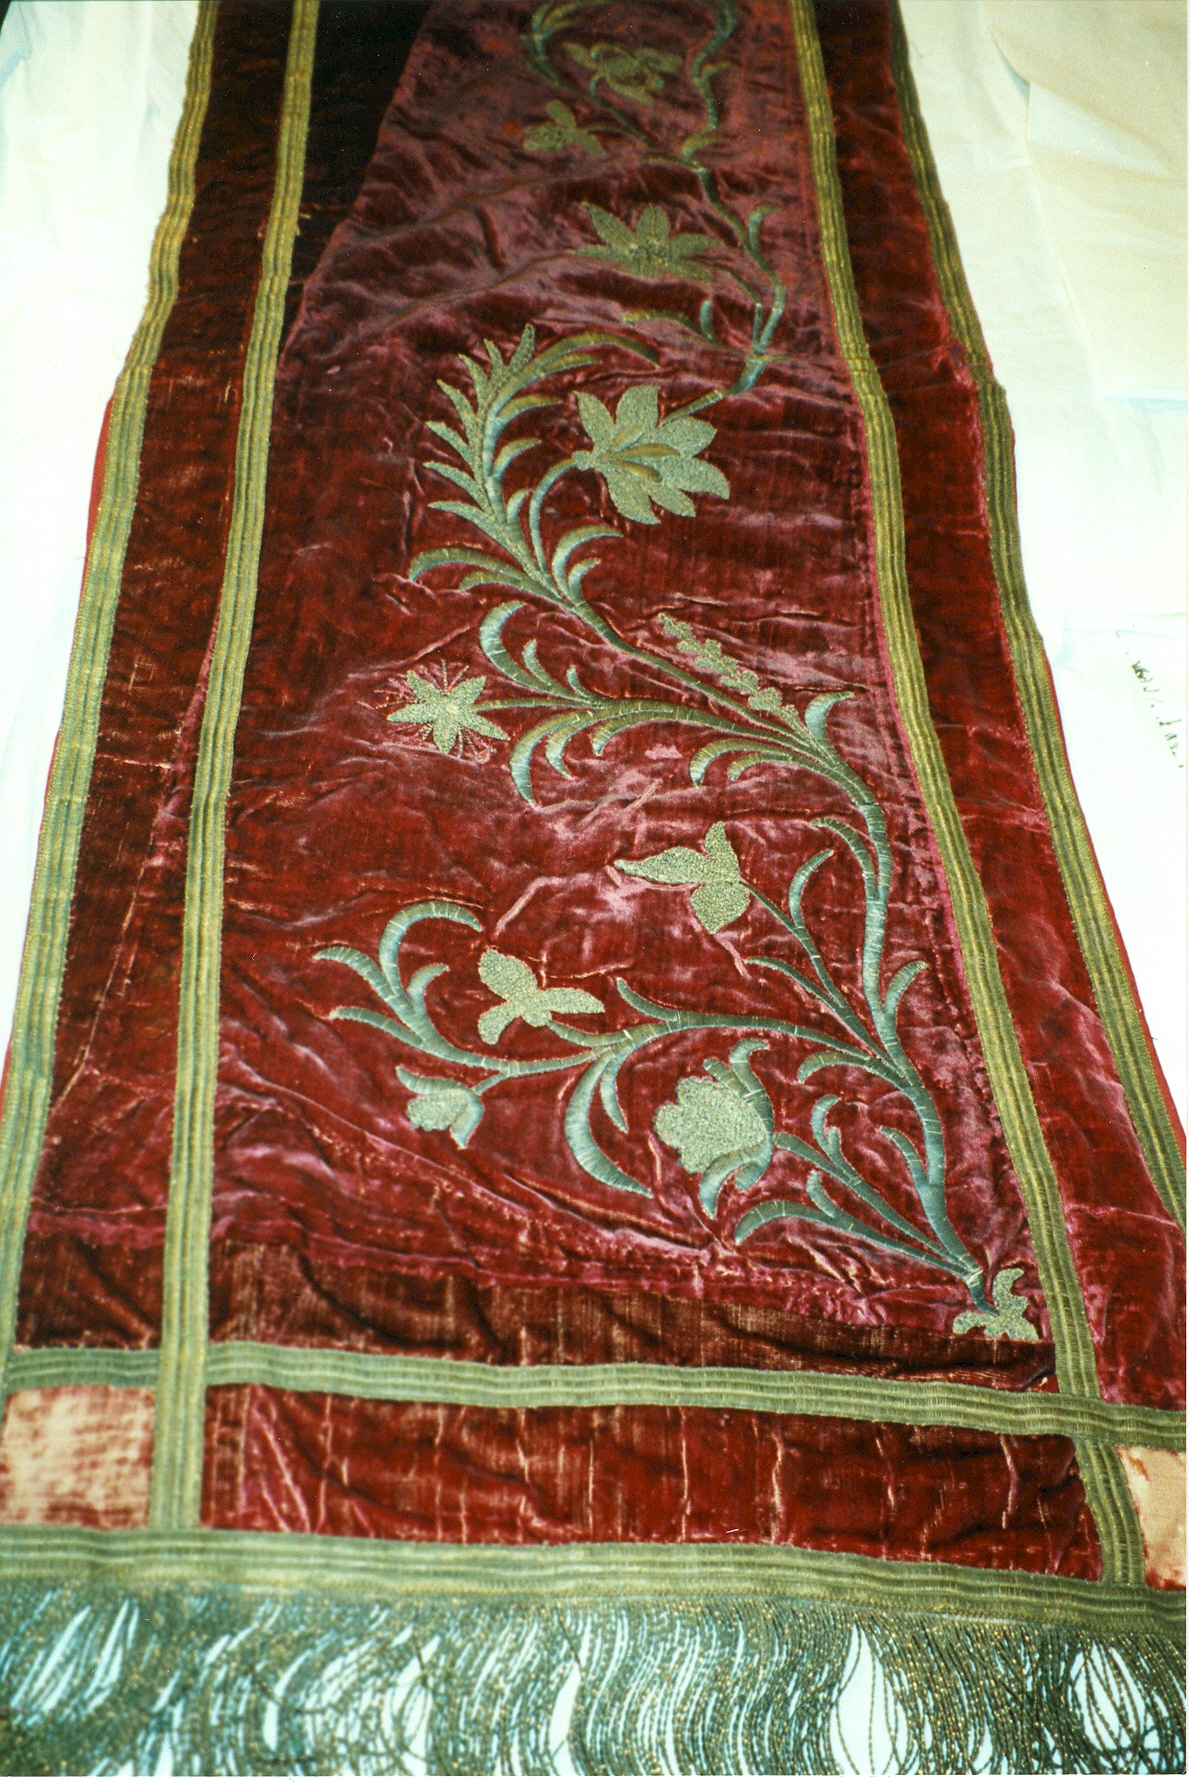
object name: textile panel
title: Panel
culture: italian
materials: cardboard, metal, silk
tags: flowers